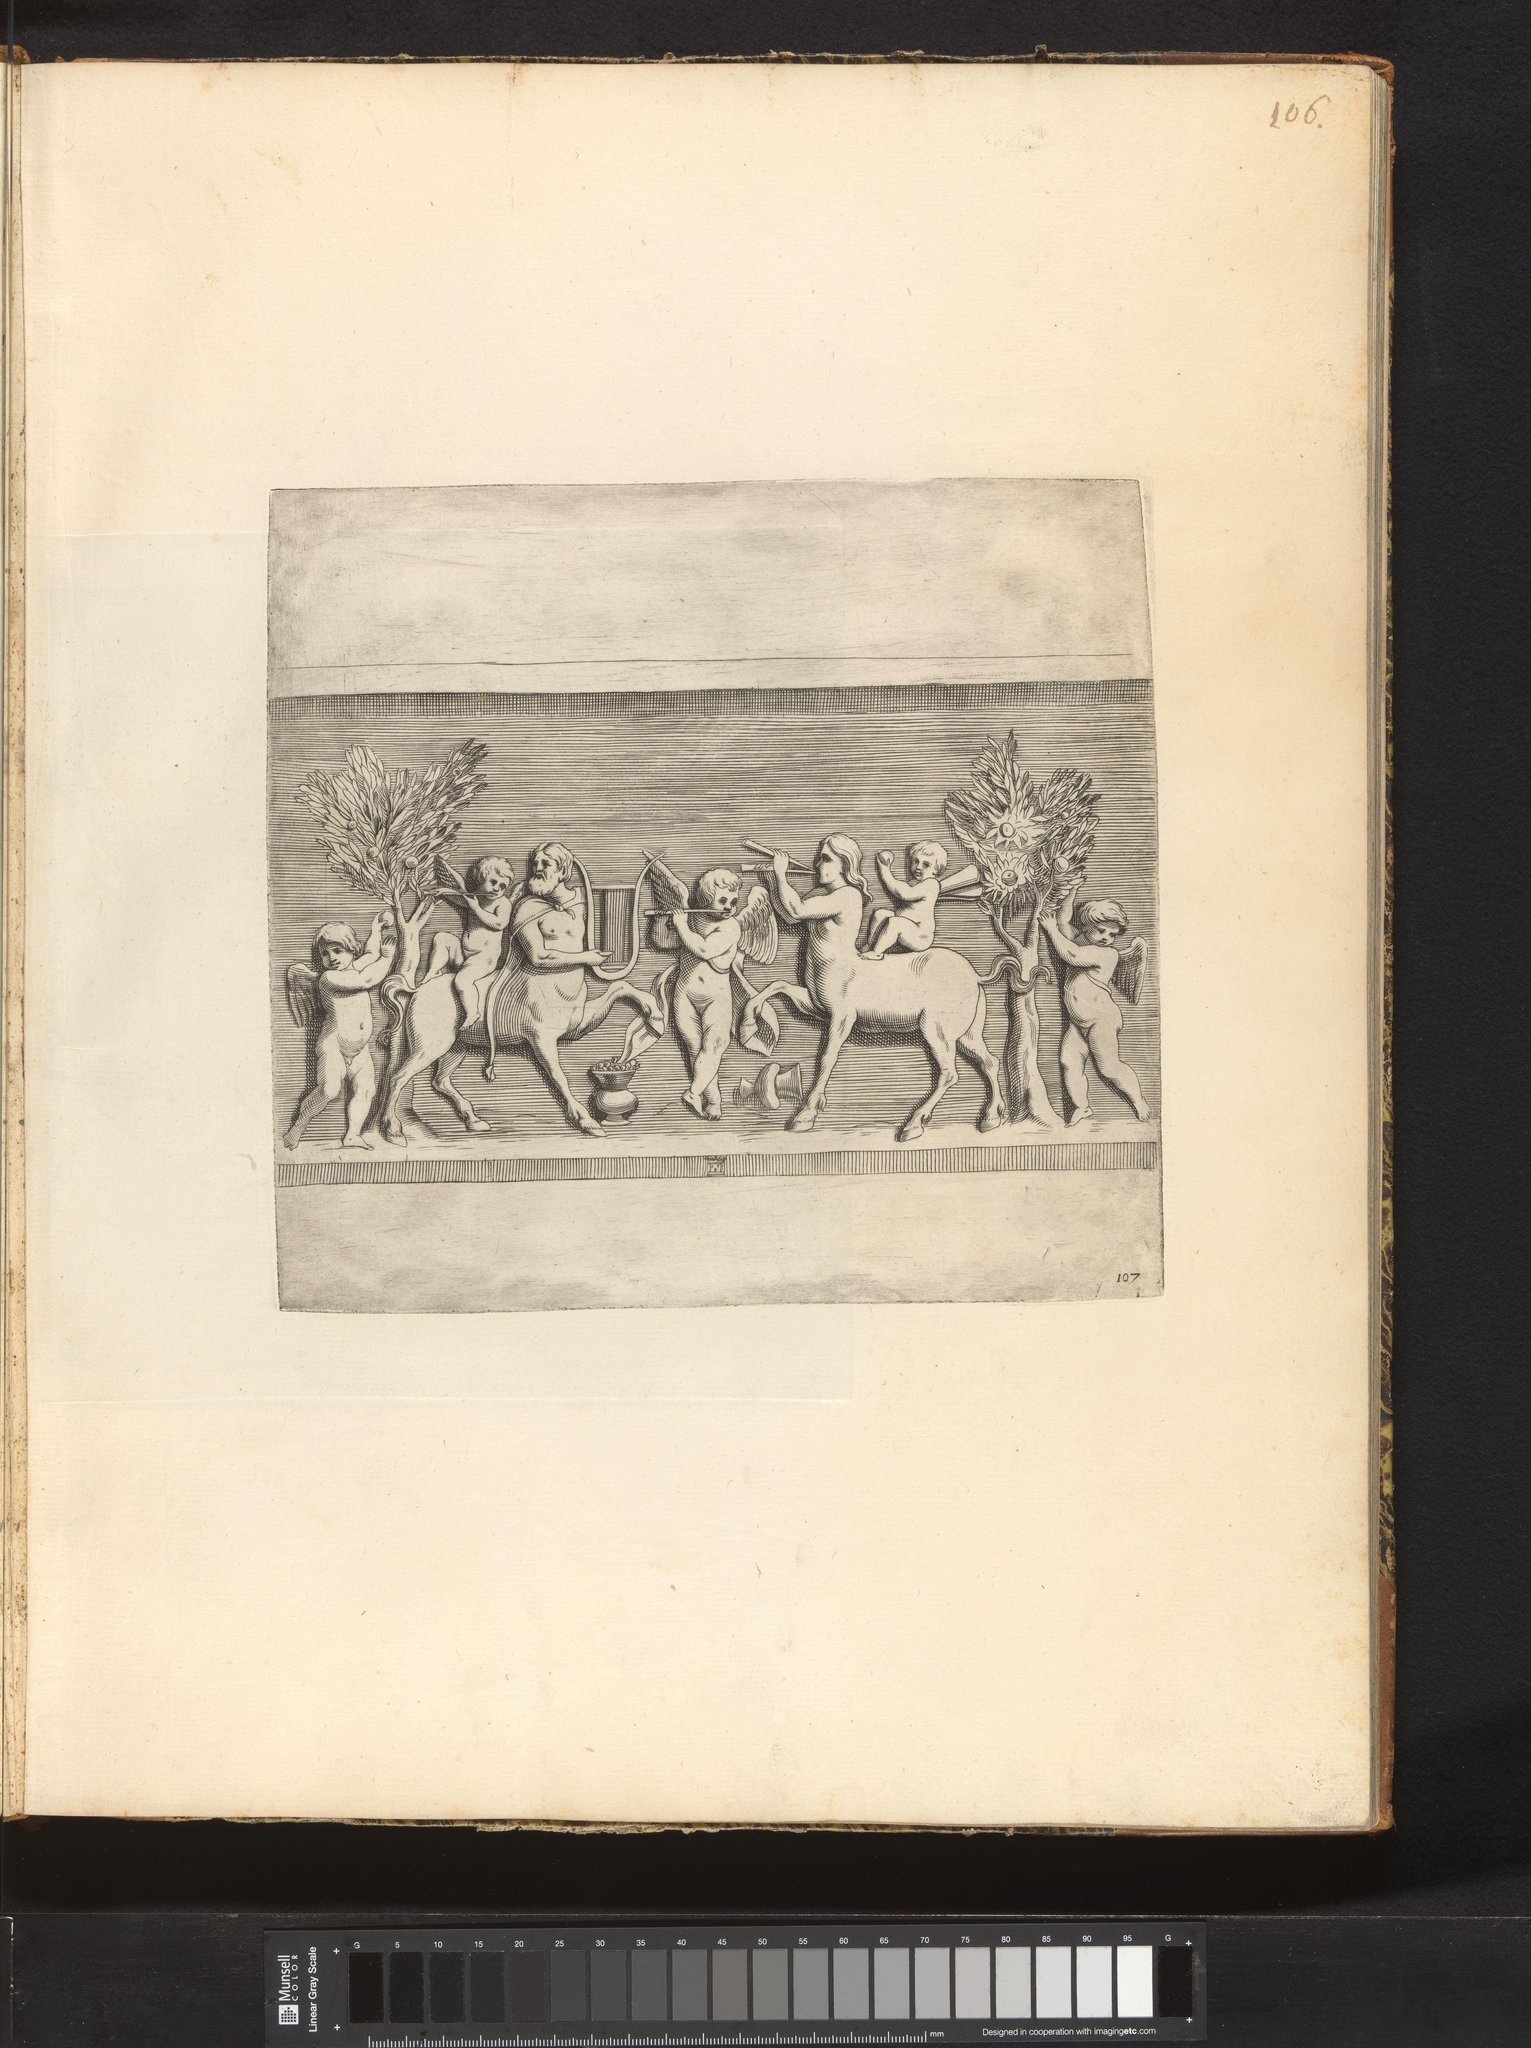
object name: print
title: Galleria Giustiniana del Marchese Vincenzo Giustiniani II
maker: nicolò lorenese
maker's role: draughtsman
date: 1636-1647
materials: paper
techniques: engraving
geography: rome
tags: diana (luna) visiting the sleeping endymion, piece of sculpture, reproduction of a piece of sculpture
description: Bas-reliëf met Diana en Endymion. Diana stapt uit haar wagen om de slapende Endymion, die rechts ligt, te bezoeken. Midden onder het wapenschild van Vincenzo Giustiniani. Prent maakt deel uit van een album met een serie prenten naar de sculpturen in de verzameling in de Galleria Giustiniani te Rome.